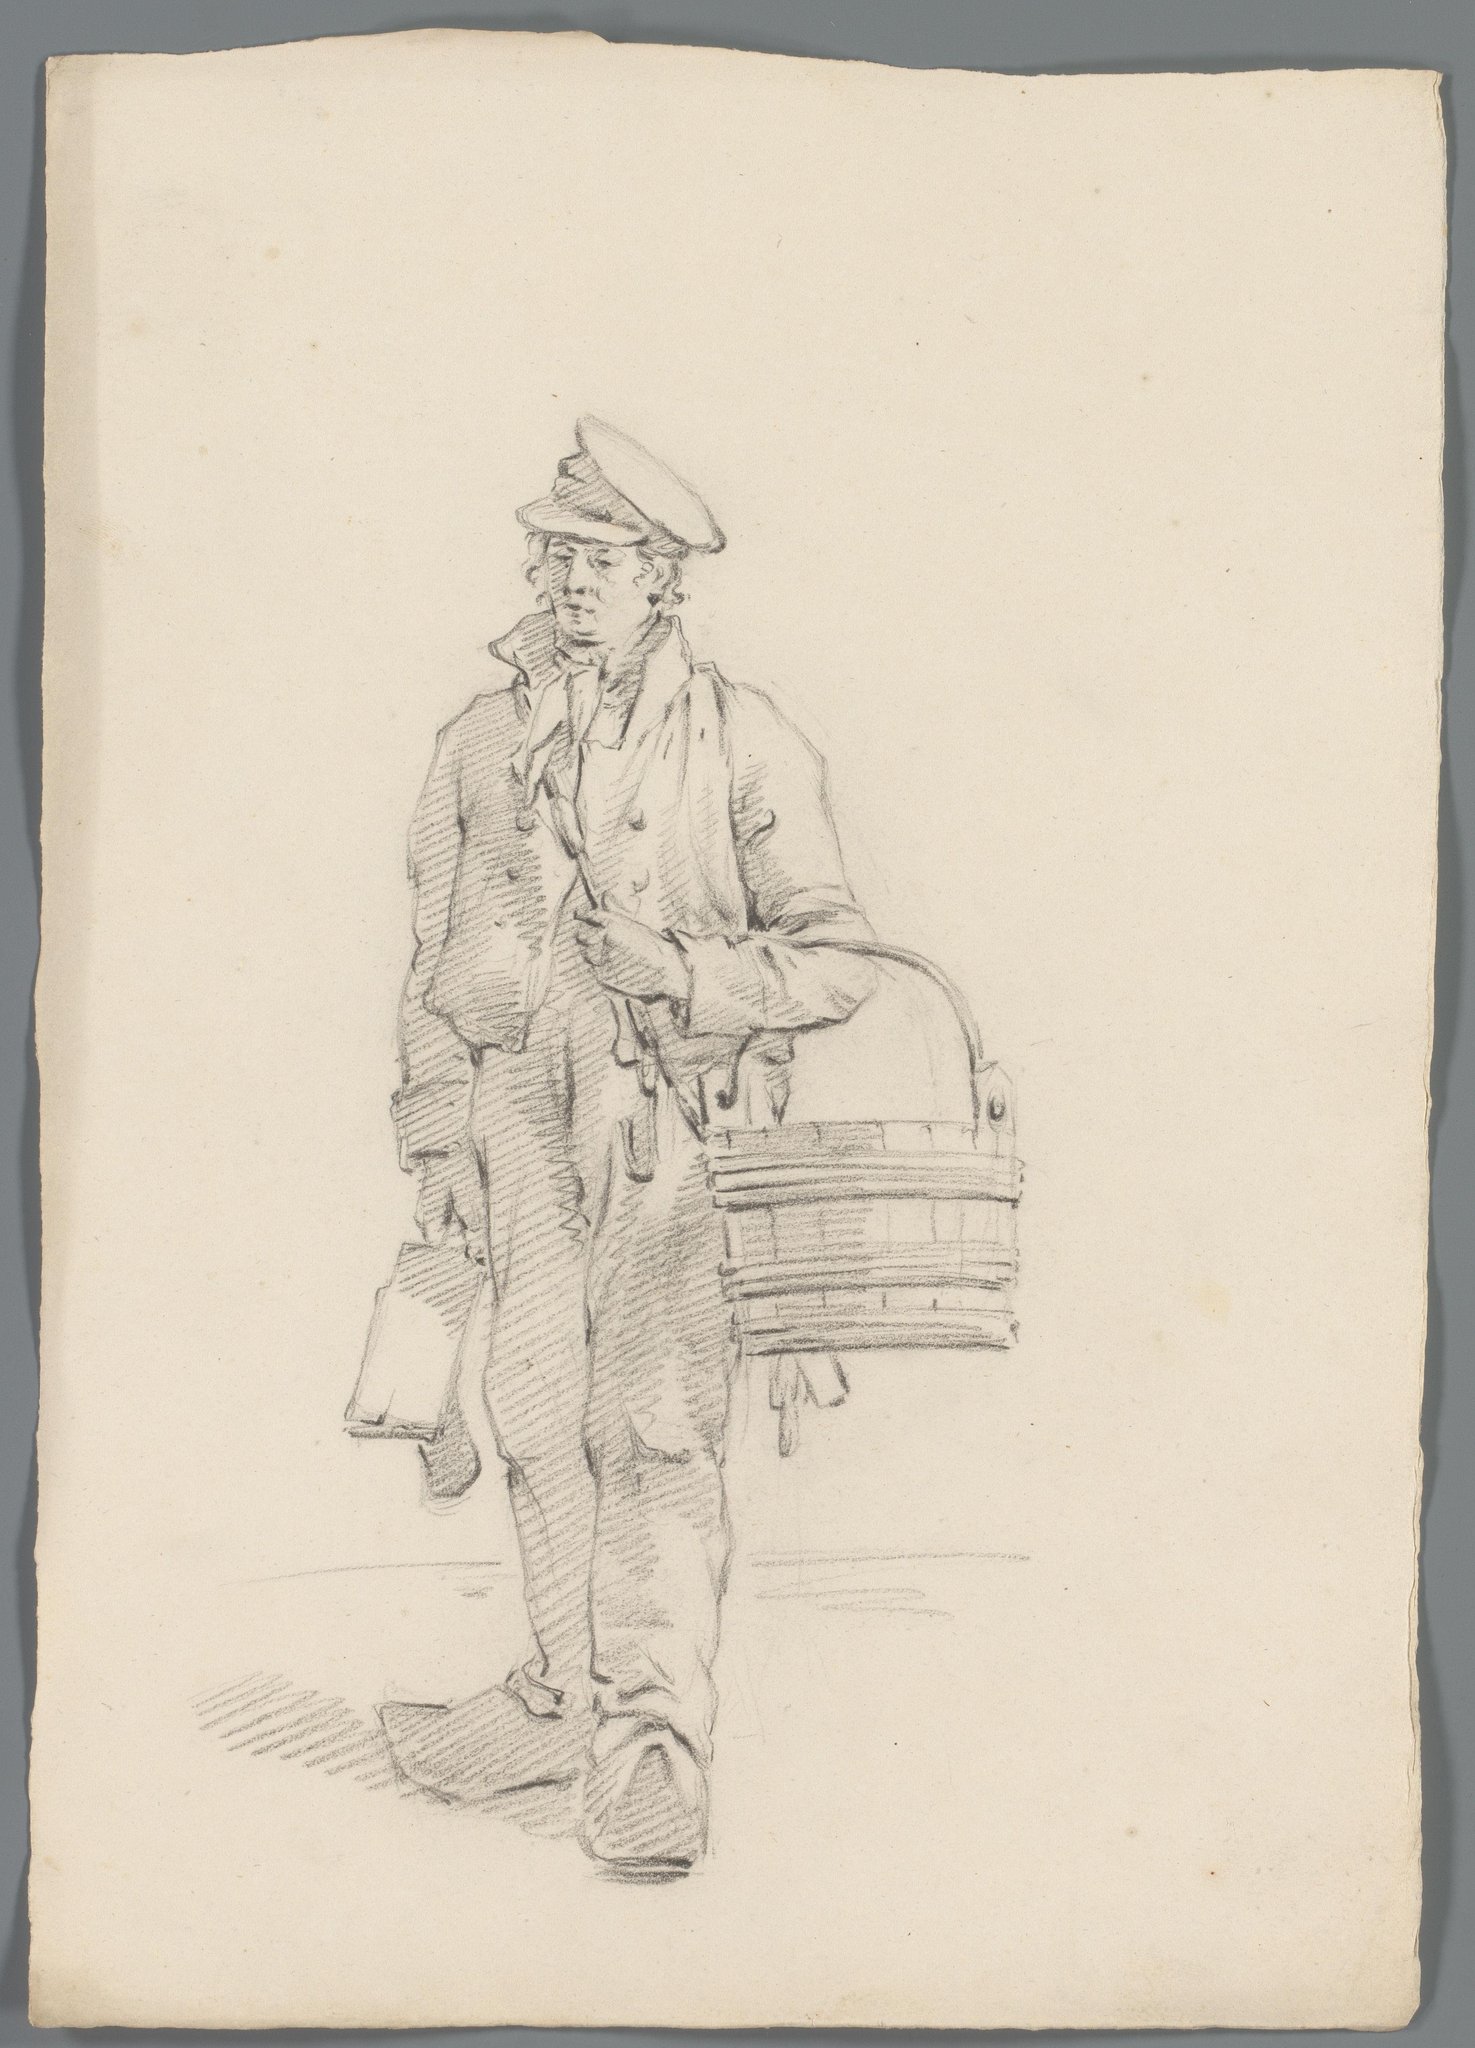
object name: drawing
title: Man met een emmer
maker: Anonymous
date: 1820-1830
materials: chalk, paper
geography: the hague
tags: wooden container: barrel, cask, bucket, wooden shoes, clogs, adult man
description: Tekeningen waarschijnlijk ontstaan bij het Haagse kunstgenootschap ‘Tot Nut der Tekenkunst’, waar twee keer per week tekenavonden werden georganiseerd met geklede modellen.